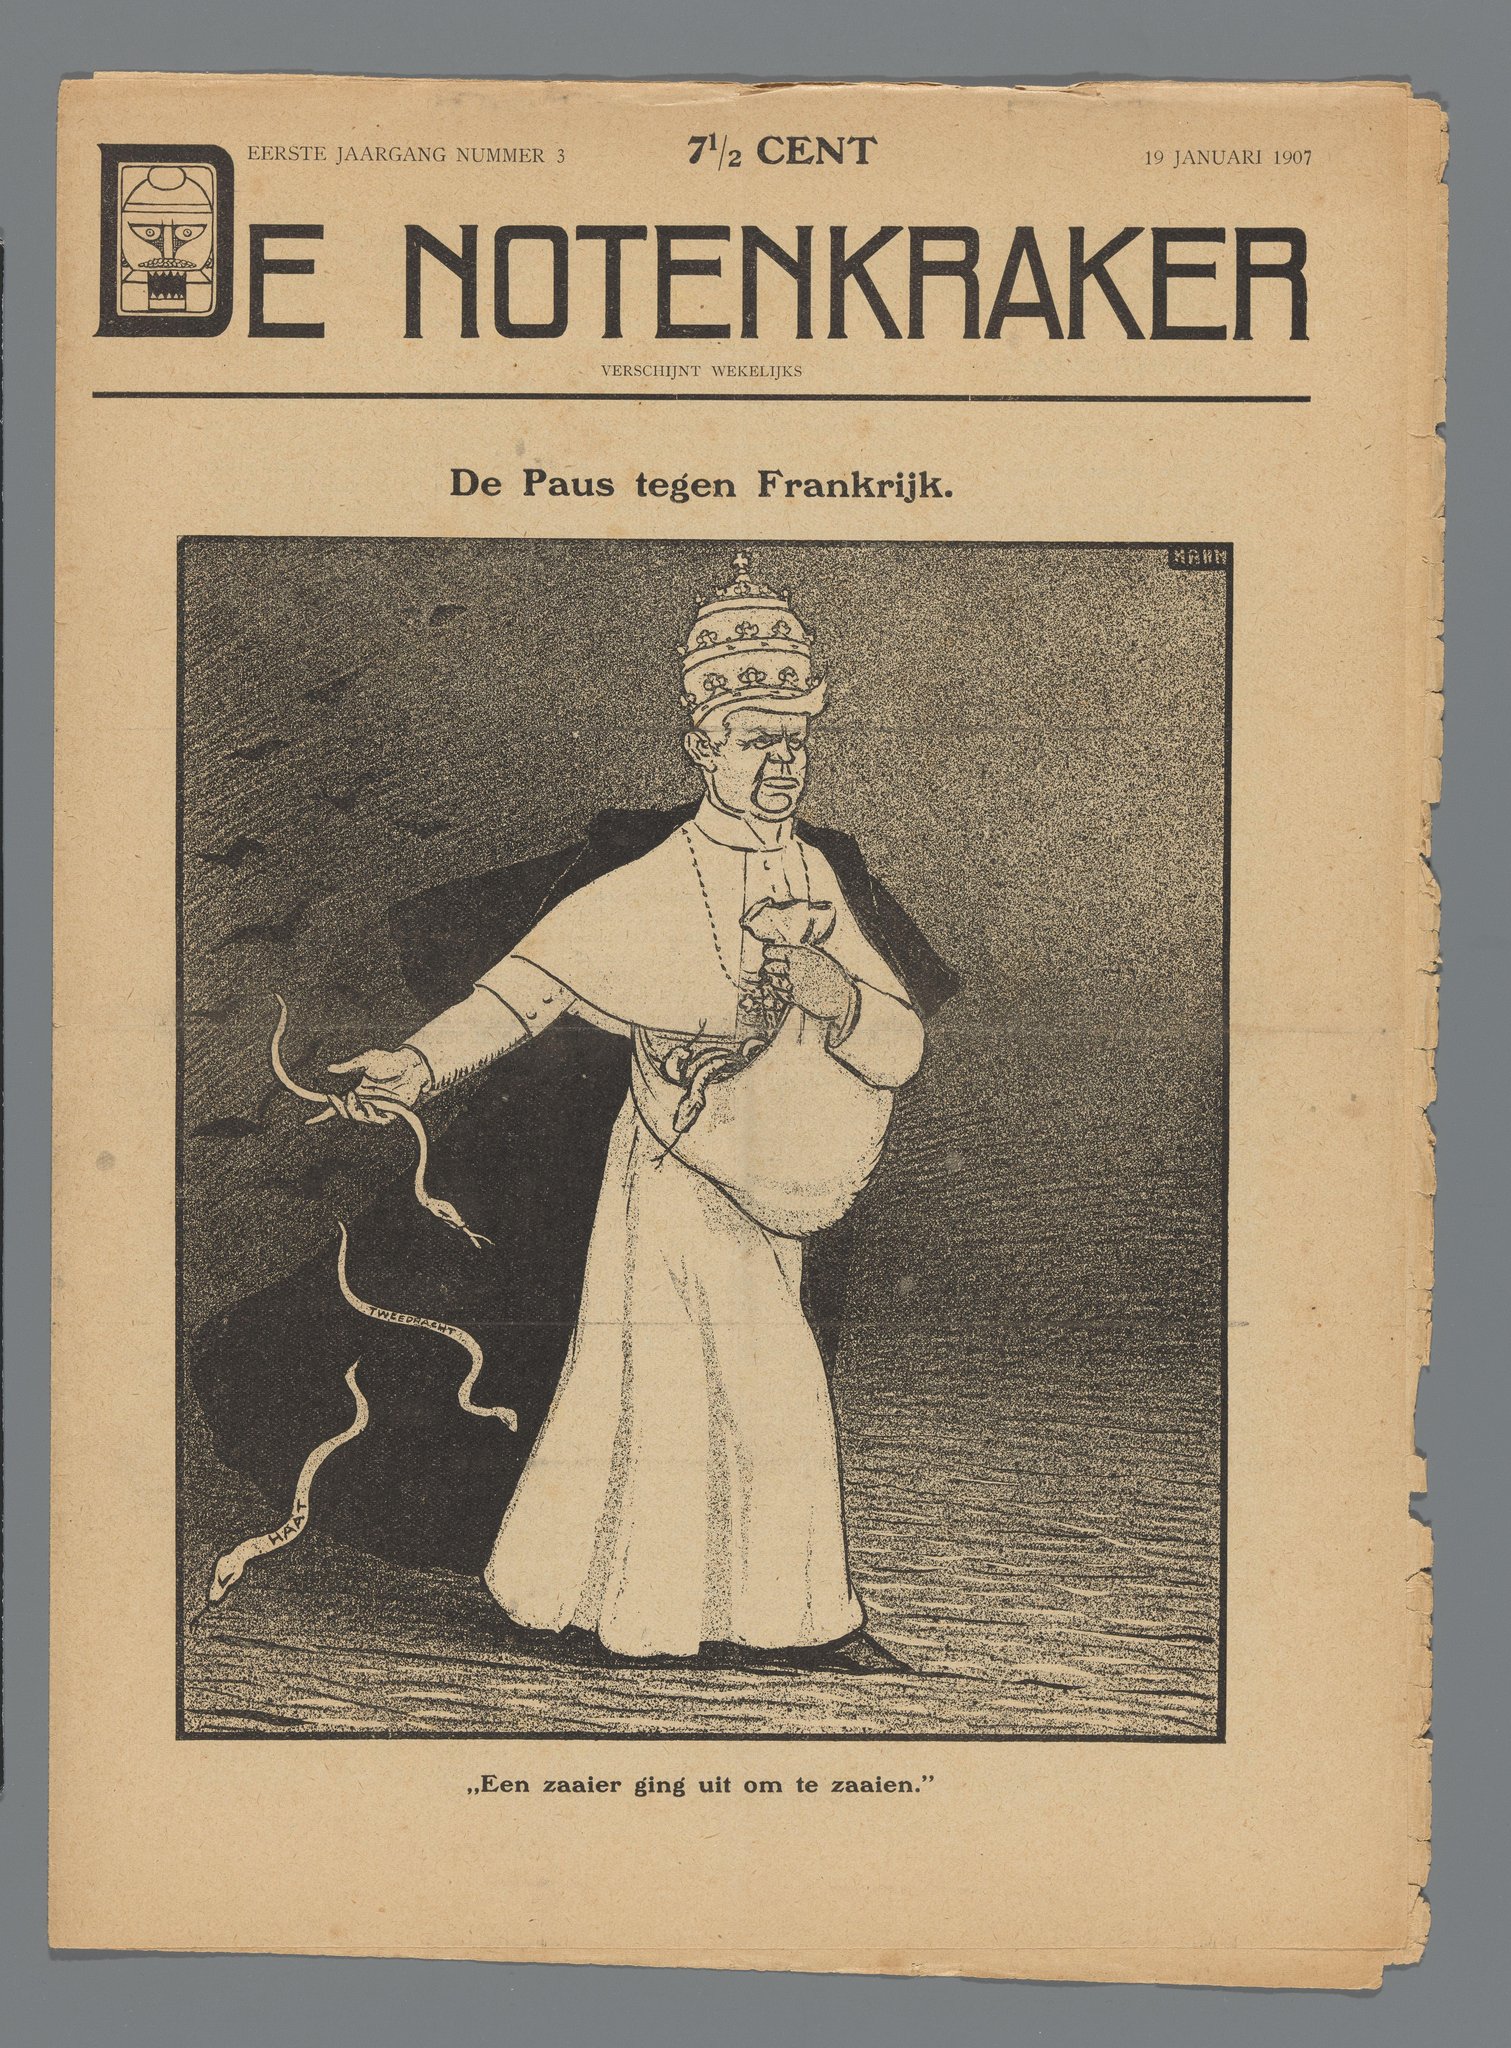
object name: magazine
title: De Notenkraker, 19 januari 1907: De Paus tegen Frankrijk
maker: albert hahn (i)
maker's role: draughtsman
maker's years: 1877-1918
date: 1907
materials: paper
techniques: lithograph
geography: netherlands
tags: venice, rome, sowing, political caricatures and satires, france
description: Aflevering van het satirische tijdschrift De Notenkraker van 19 januari 1907, eerste jaargang, nummer 3. Omslag met illustratie van paus Pius X die haat en tweedracht zaait. Onderdeel van een volledige eerste jaargang (1907). Elk nummer bevat 8 bladzijden, deels nog niet losgesneden, met op de voorzijde steeds een spotprent van Albert Hahn, op de overige pagina's prenten van Hahn steeds tussen de tekst. In de letter 'D' van de titel is een kop van een zgn. notenkraker afgebeeld.